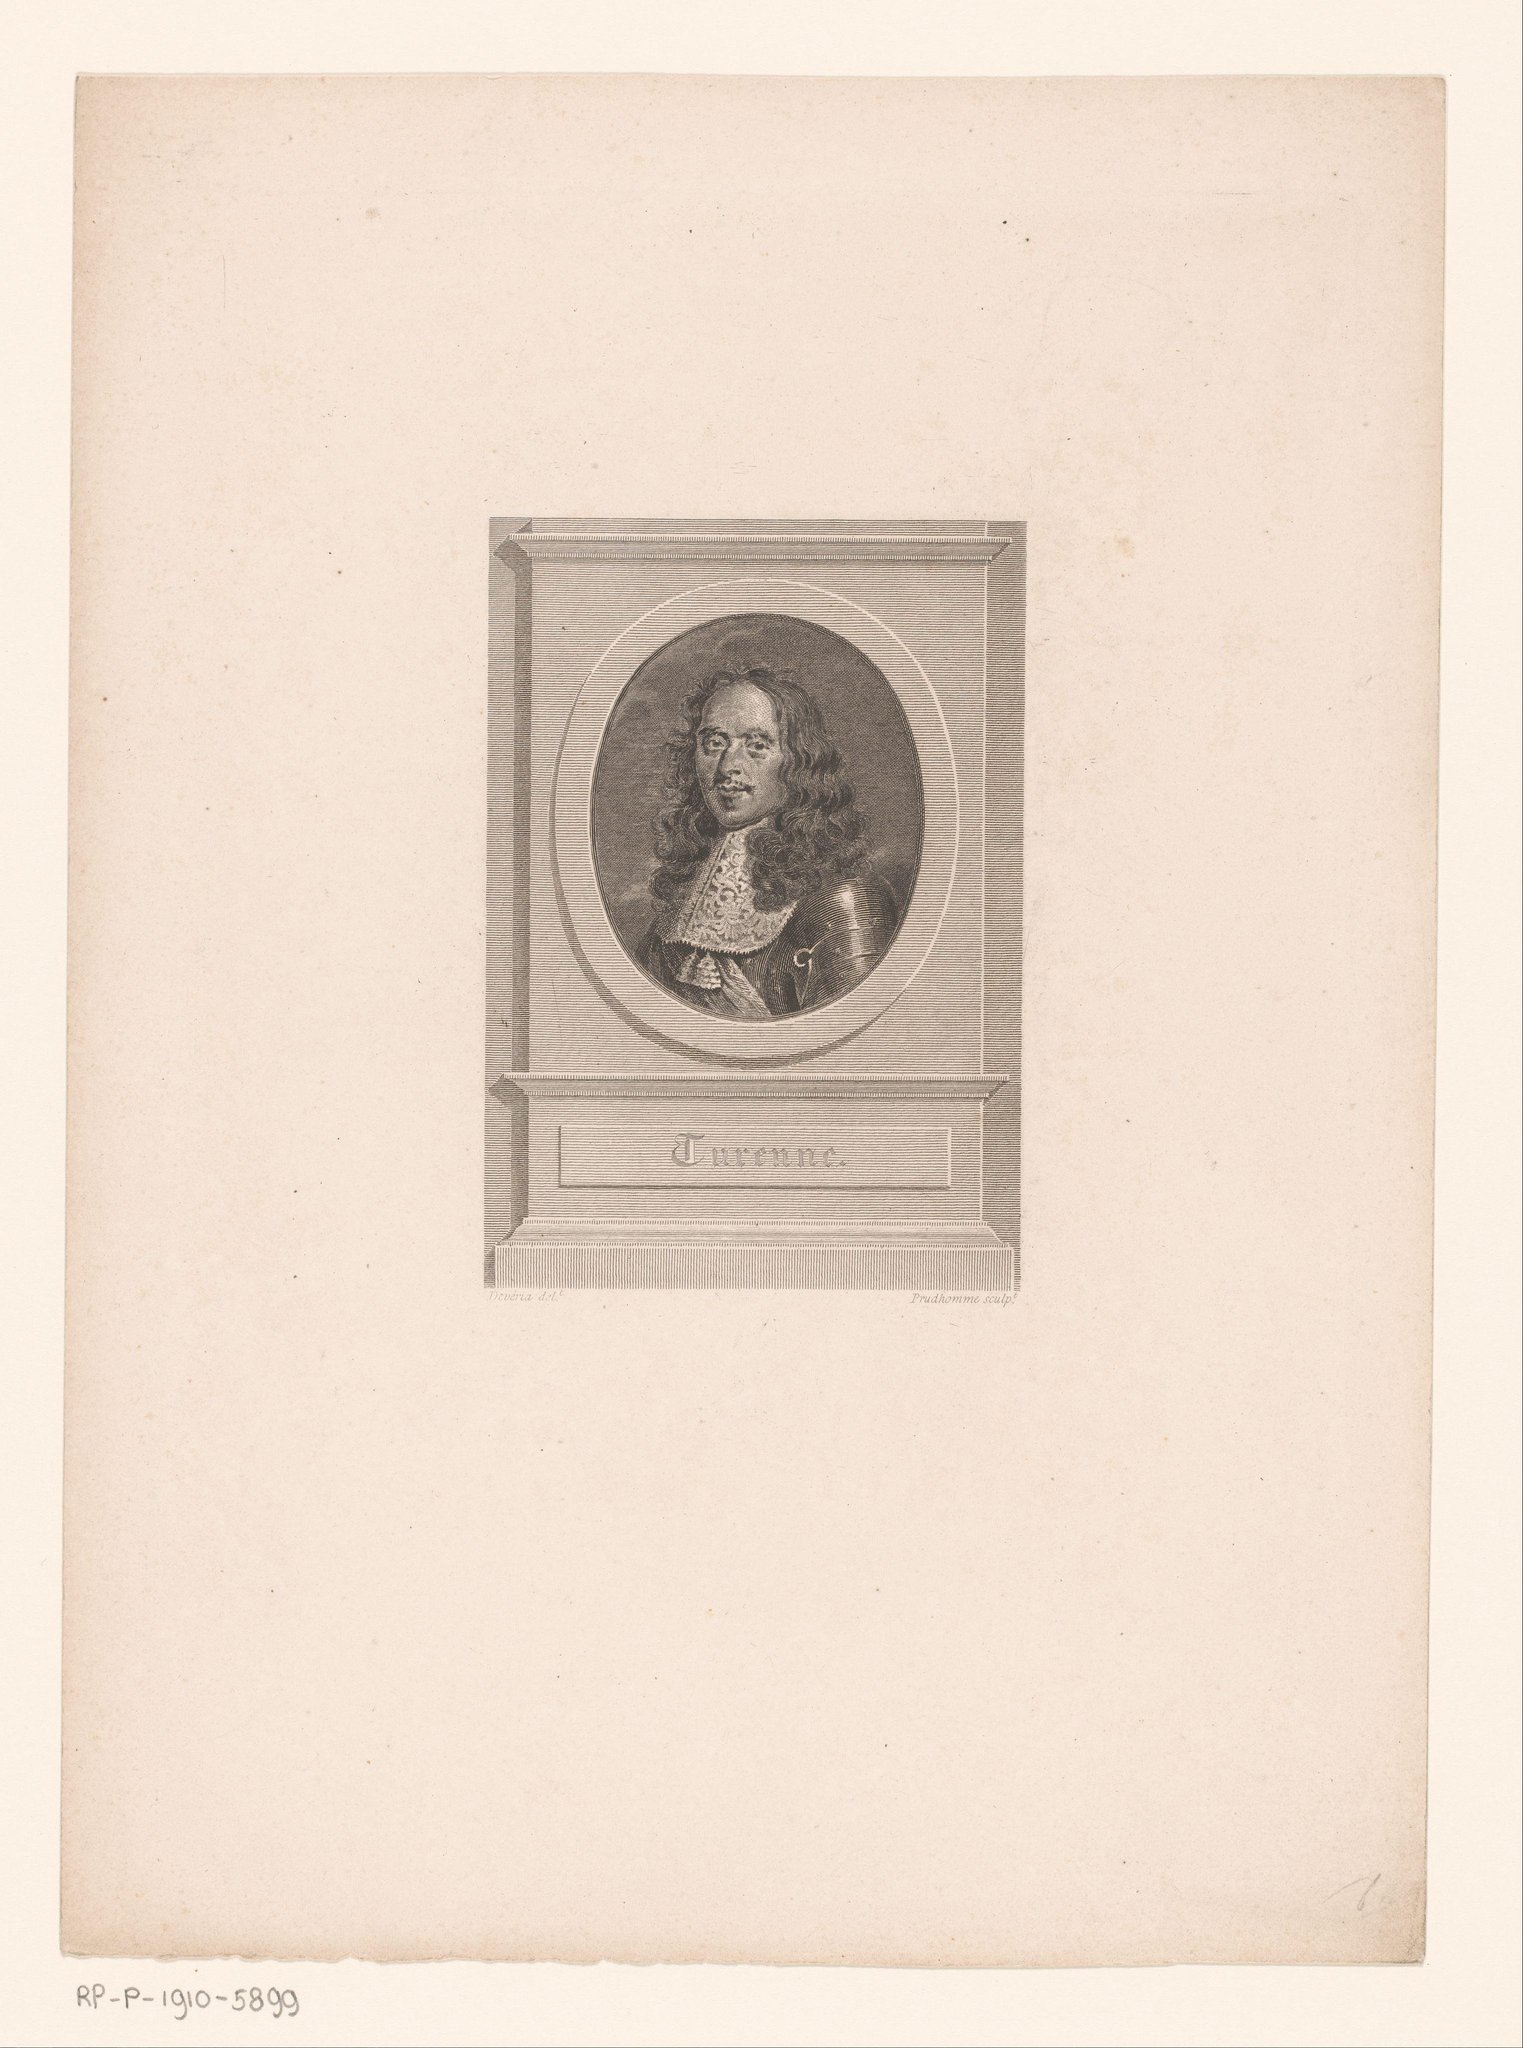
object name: print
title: Portret van Henri de la Tour d'Auvergne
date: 1820-1830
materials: paper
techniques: engraving, etching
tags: commander-in-chief, general, marshal, historical persons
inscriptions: collector's mark: Lugt 2228